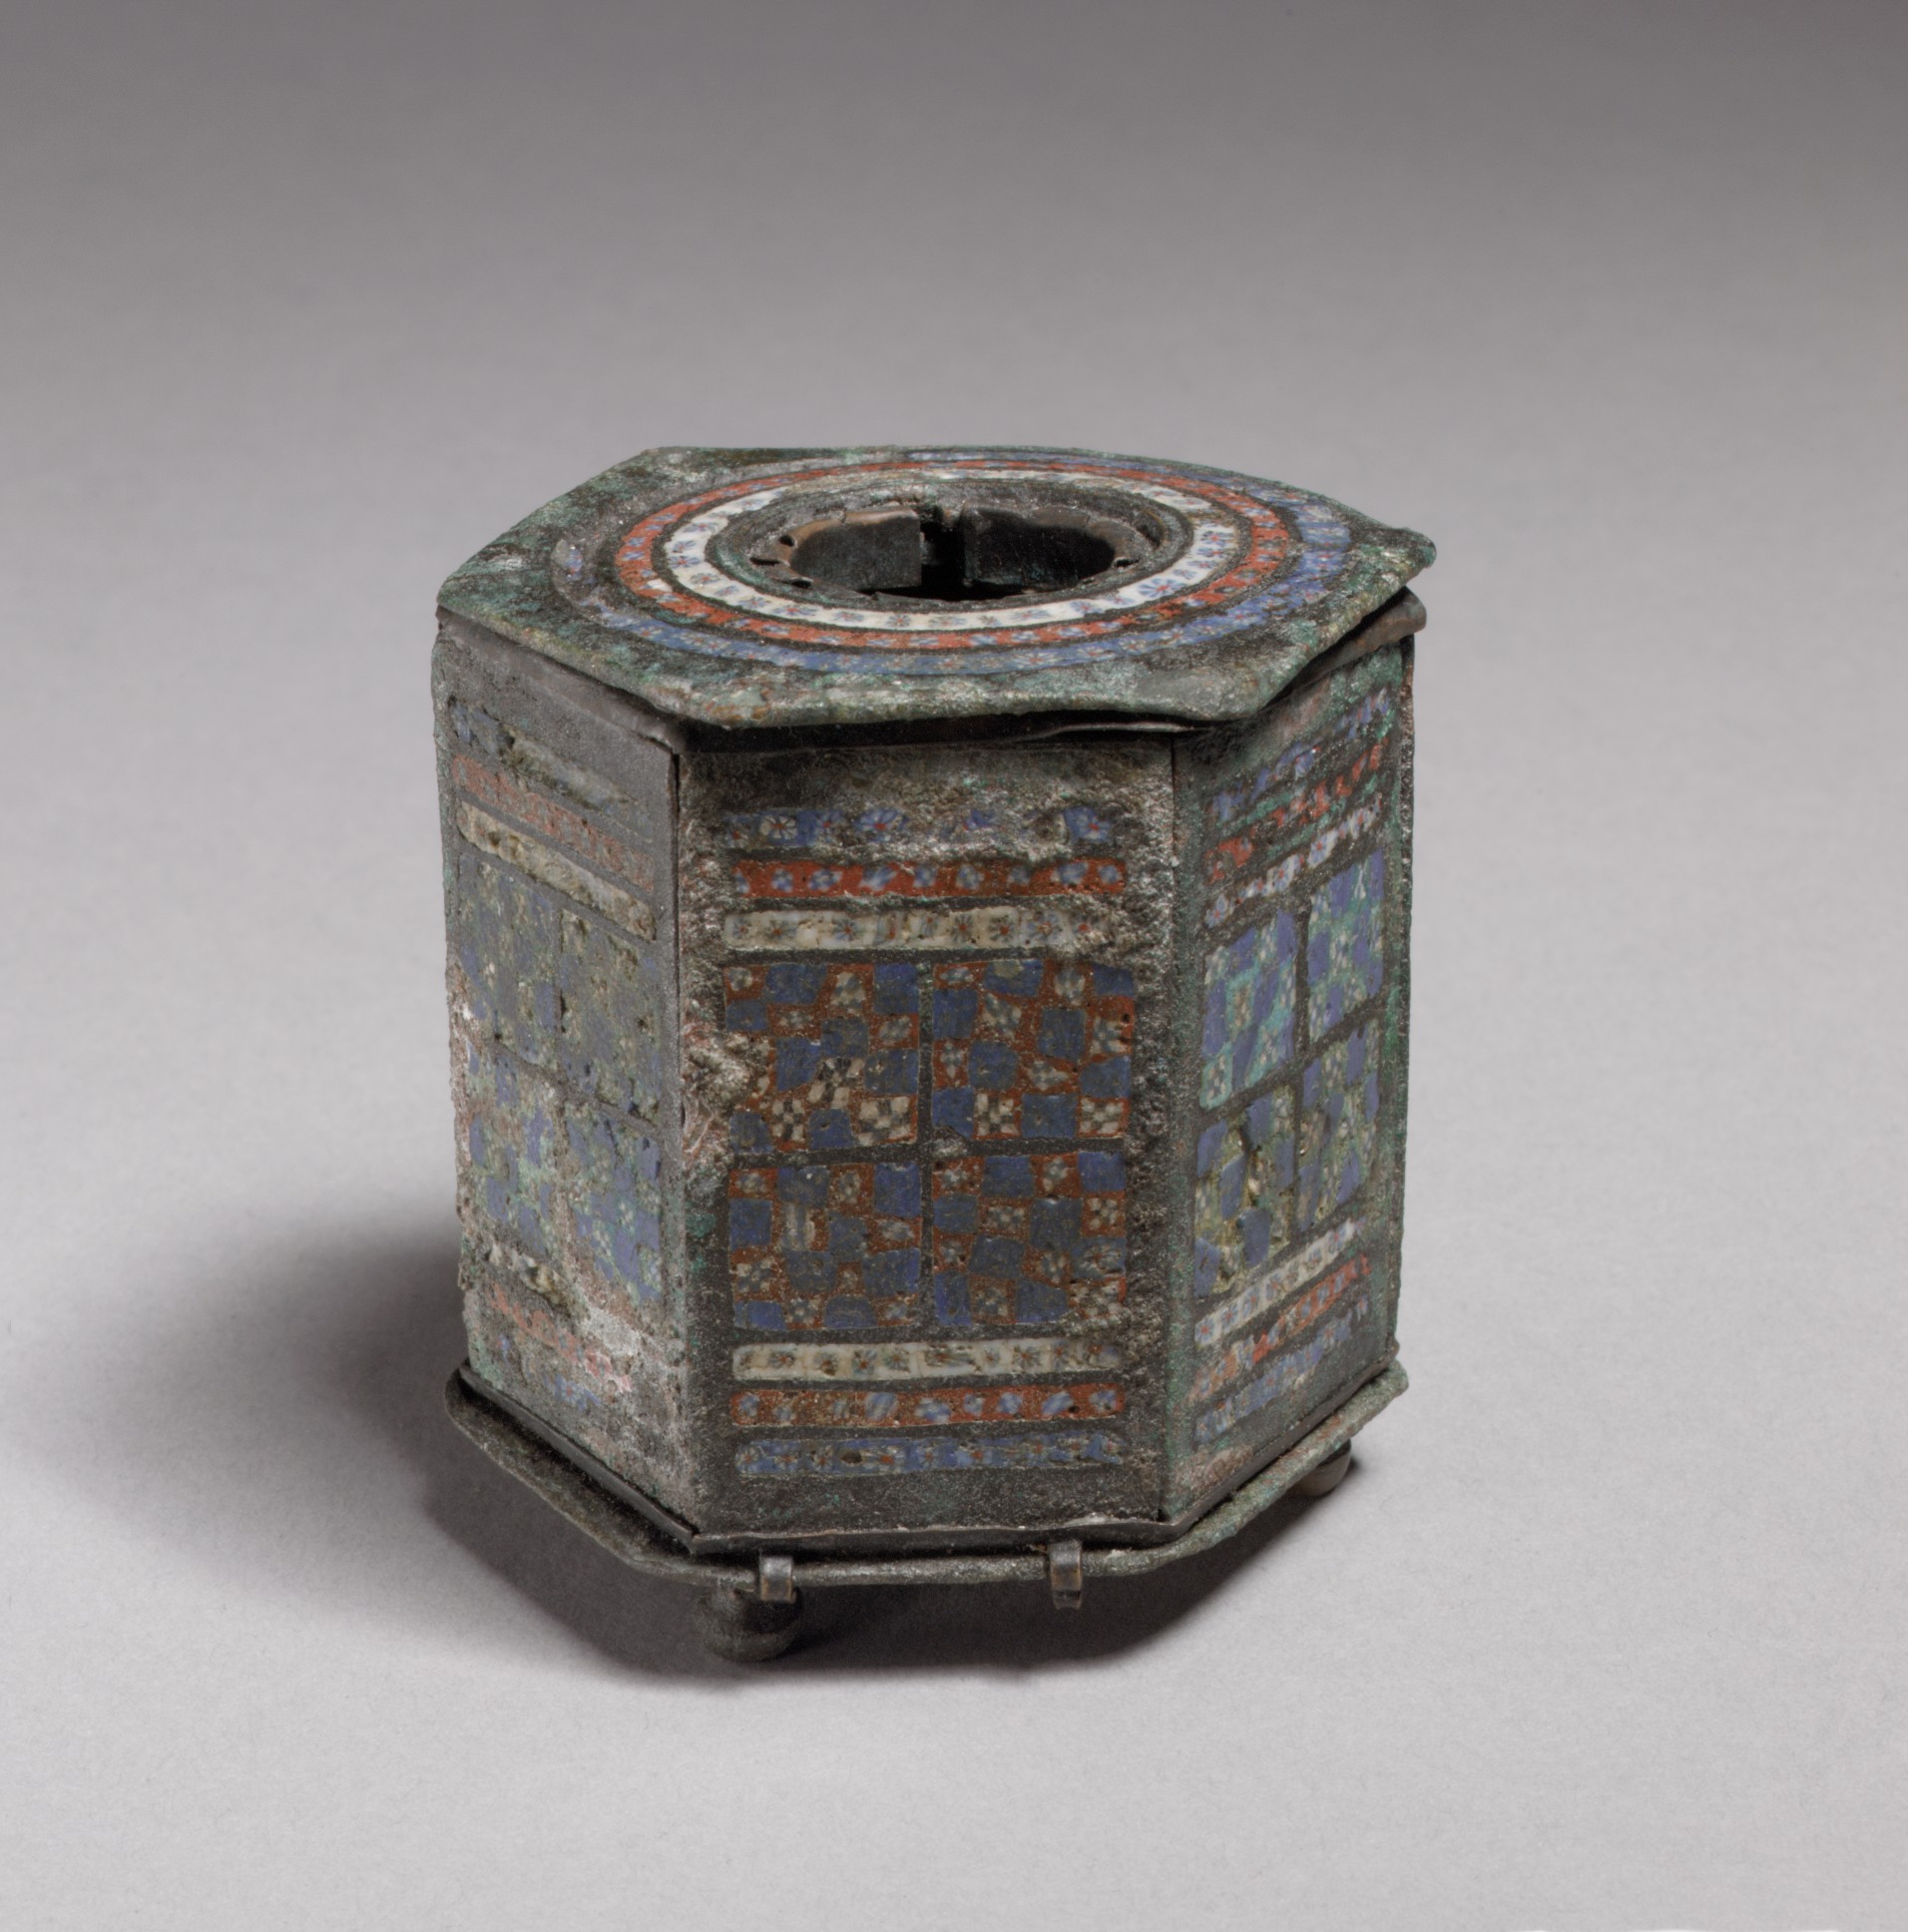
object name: pyx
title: Six-Sided Box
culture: roman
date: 201-300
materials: bronze, enamel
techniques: enamel, inlay